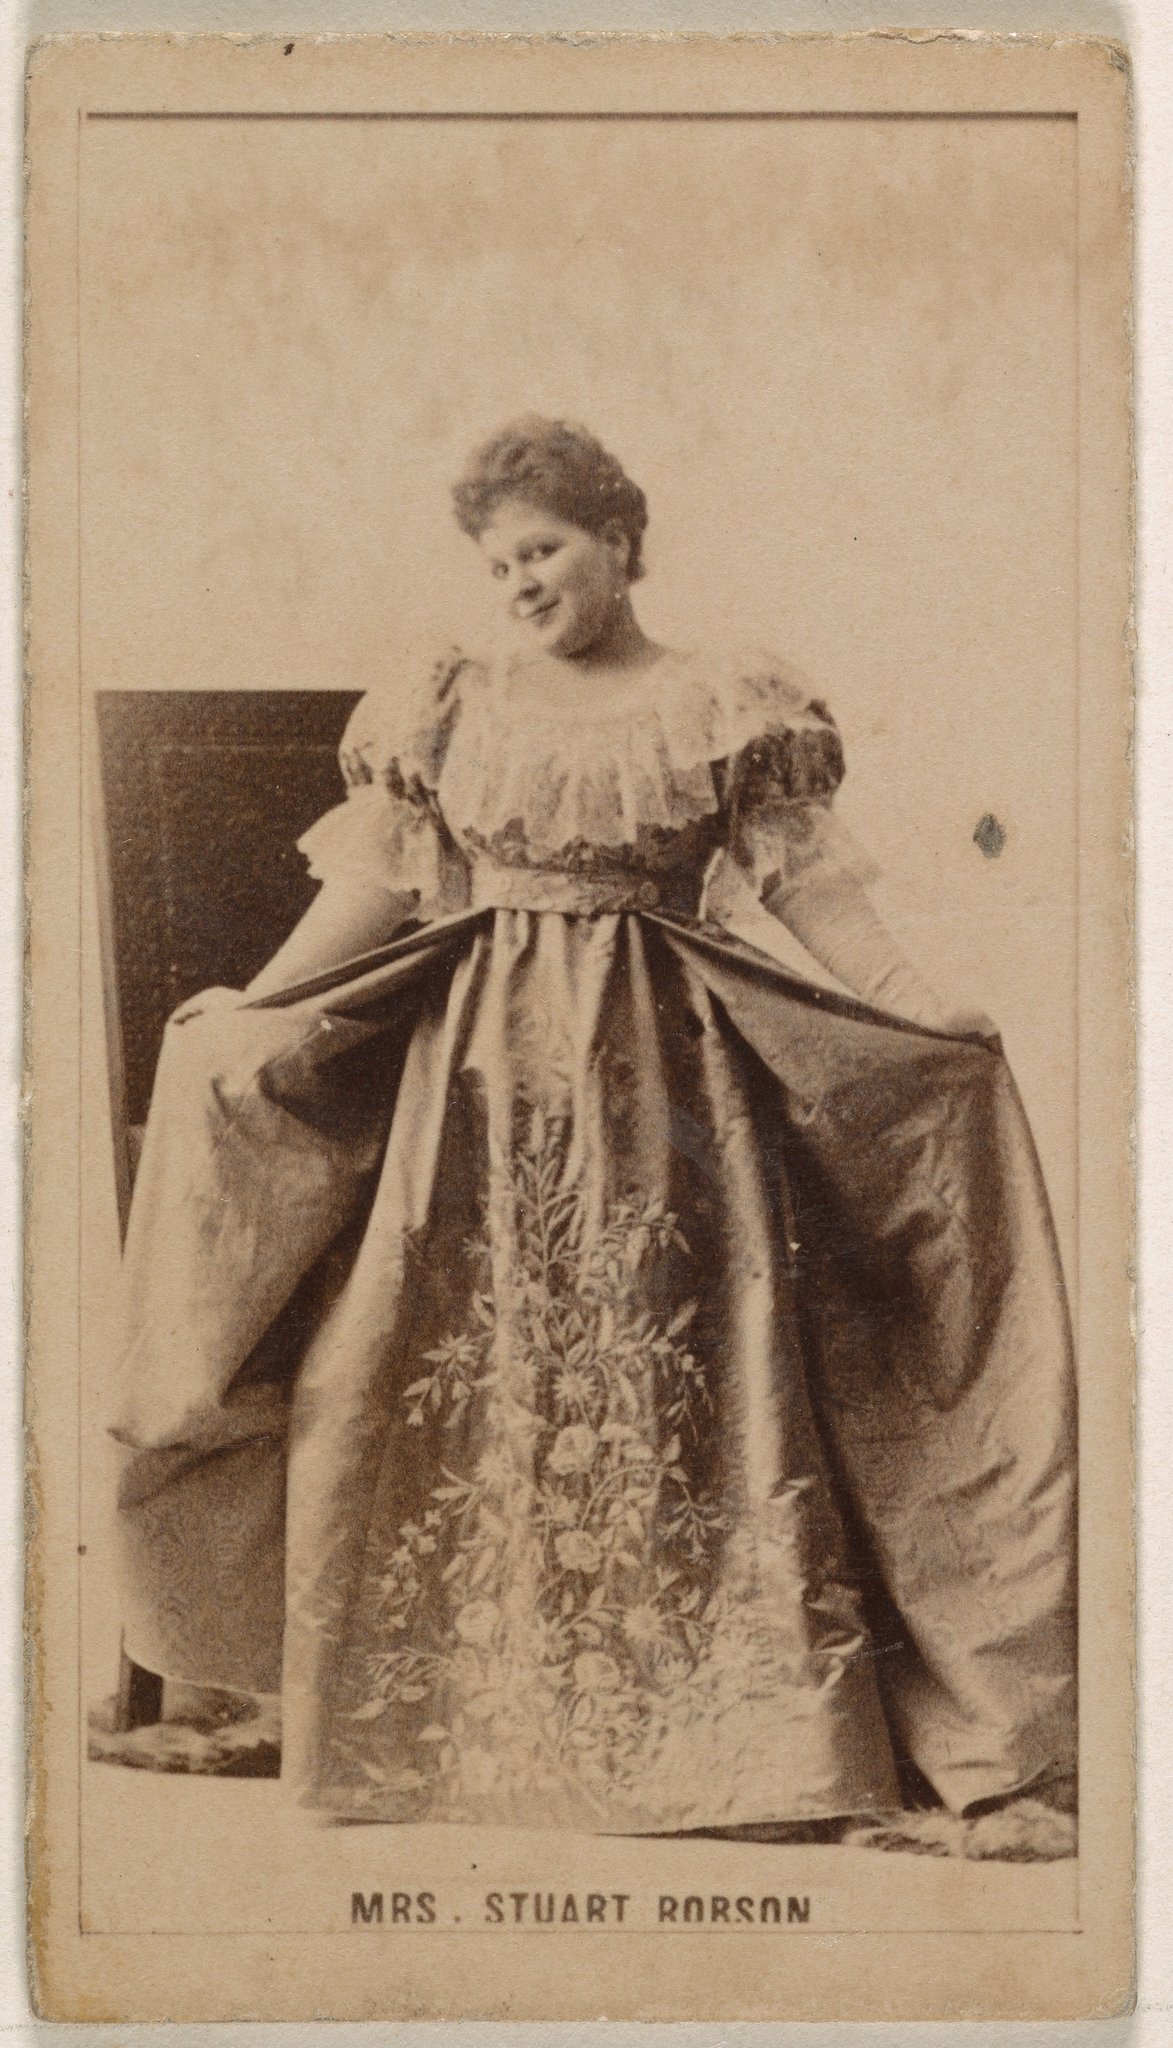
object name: photograph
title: Mrs. Stuart Robson, from the Actresses series (N245) issued by Kinney Brothers to promote Sweet Caporal Cigarettes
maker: kinney brothers tobacco company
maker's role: publisher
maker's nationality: american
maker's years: 1869-2011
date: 1890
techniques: albumen silver print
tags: portraits,women,actresses